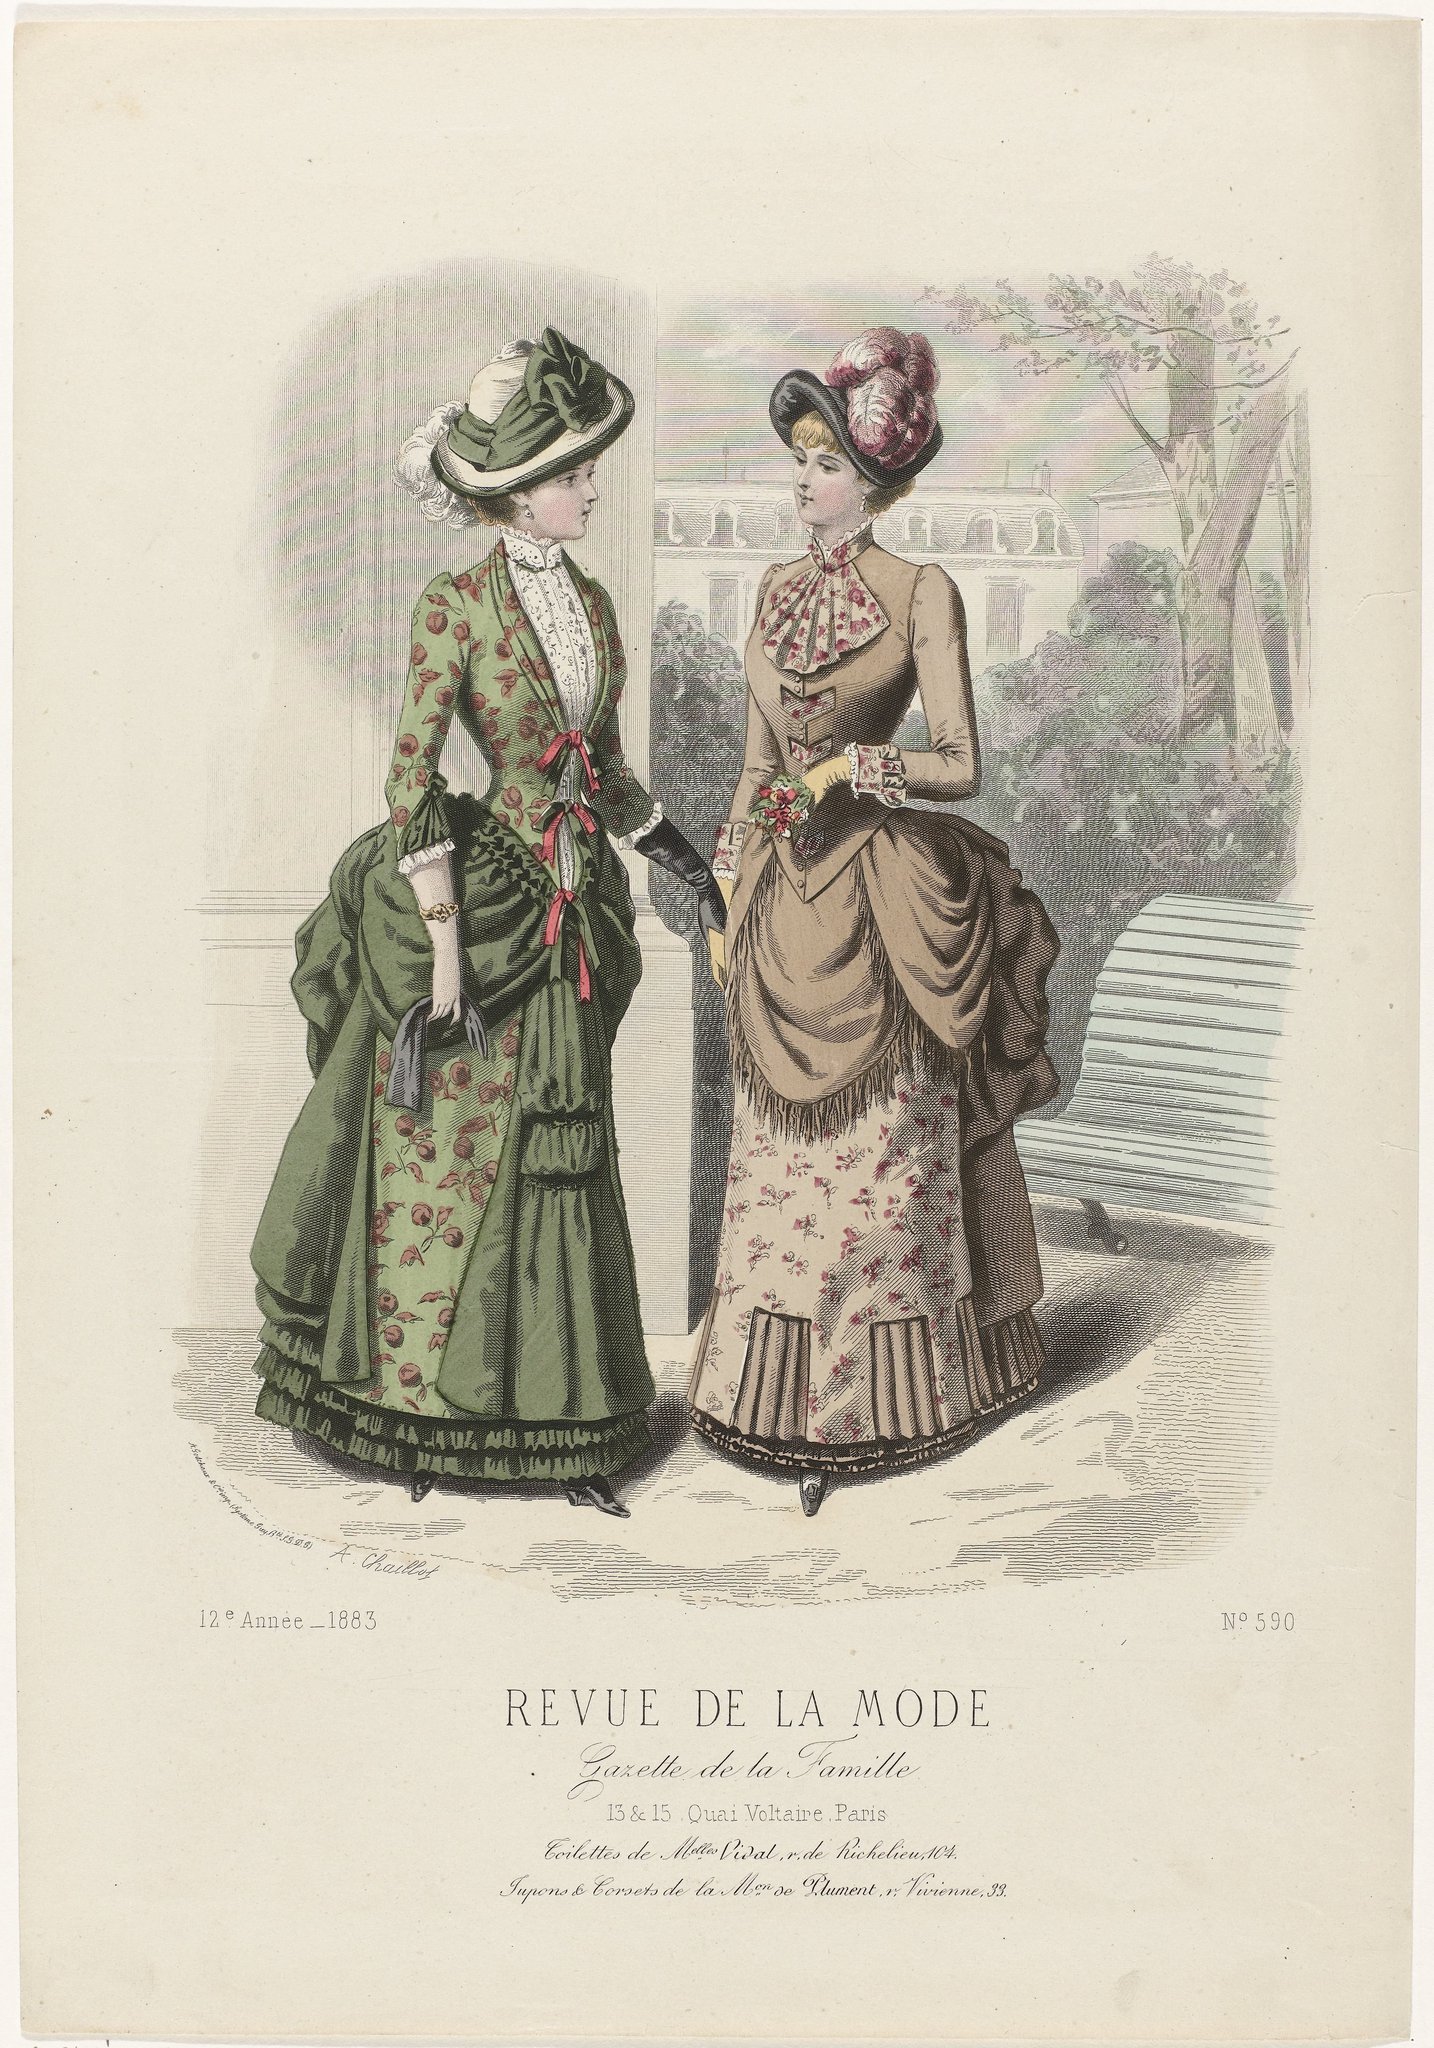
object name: fashion print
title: Revue de la Mode, Gazette de la Famille, dimanche 22 avril 1883, 12e annee, No. 590: Toilettes de Melles Vidal (...)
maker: a. chaillot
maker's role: print maker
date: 1883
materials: paper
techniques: engraving, hand coloring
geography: paris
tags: gloves, mittens (long gloves) (+ women's clothes), dress, gown: walking dress (+ women's clothes), dress, gown (robe d'intérieur) (+ women's clothes), fashion plates, head-gear: hat (+ women's clothes)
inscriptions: caption: ‘Toilettes de M.elles Vidal, r. de Richelieu, 104. Jupons & Corsets de la Mo.n de Plument, r. Vivienne, 33.’, title: ‘REVUE DE LA MODE / Gazette de la Famille’, address: ‘13 & 15, Quai Voltaire Paris’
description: Twee vrouwen bij een tuinbank, in japonnen van Vidal. Links: robe d'interieur' van mosgroene effen 'satin ottoman' (satijn) en dezelfde stof gebrocheerd. Rechts: japon van beige brocatel en effen 'tissu de fantaisie', voor de wandeling of binnenshuis. Onder de afbeelding een regel reclametekst voor verschillende producten. Prent uit het modetijdschrift Revue de la Mode (1872-1913). Uitgebreide beschrijving van de kleding op pagina 122 "PLANCHE COLORIÉE".